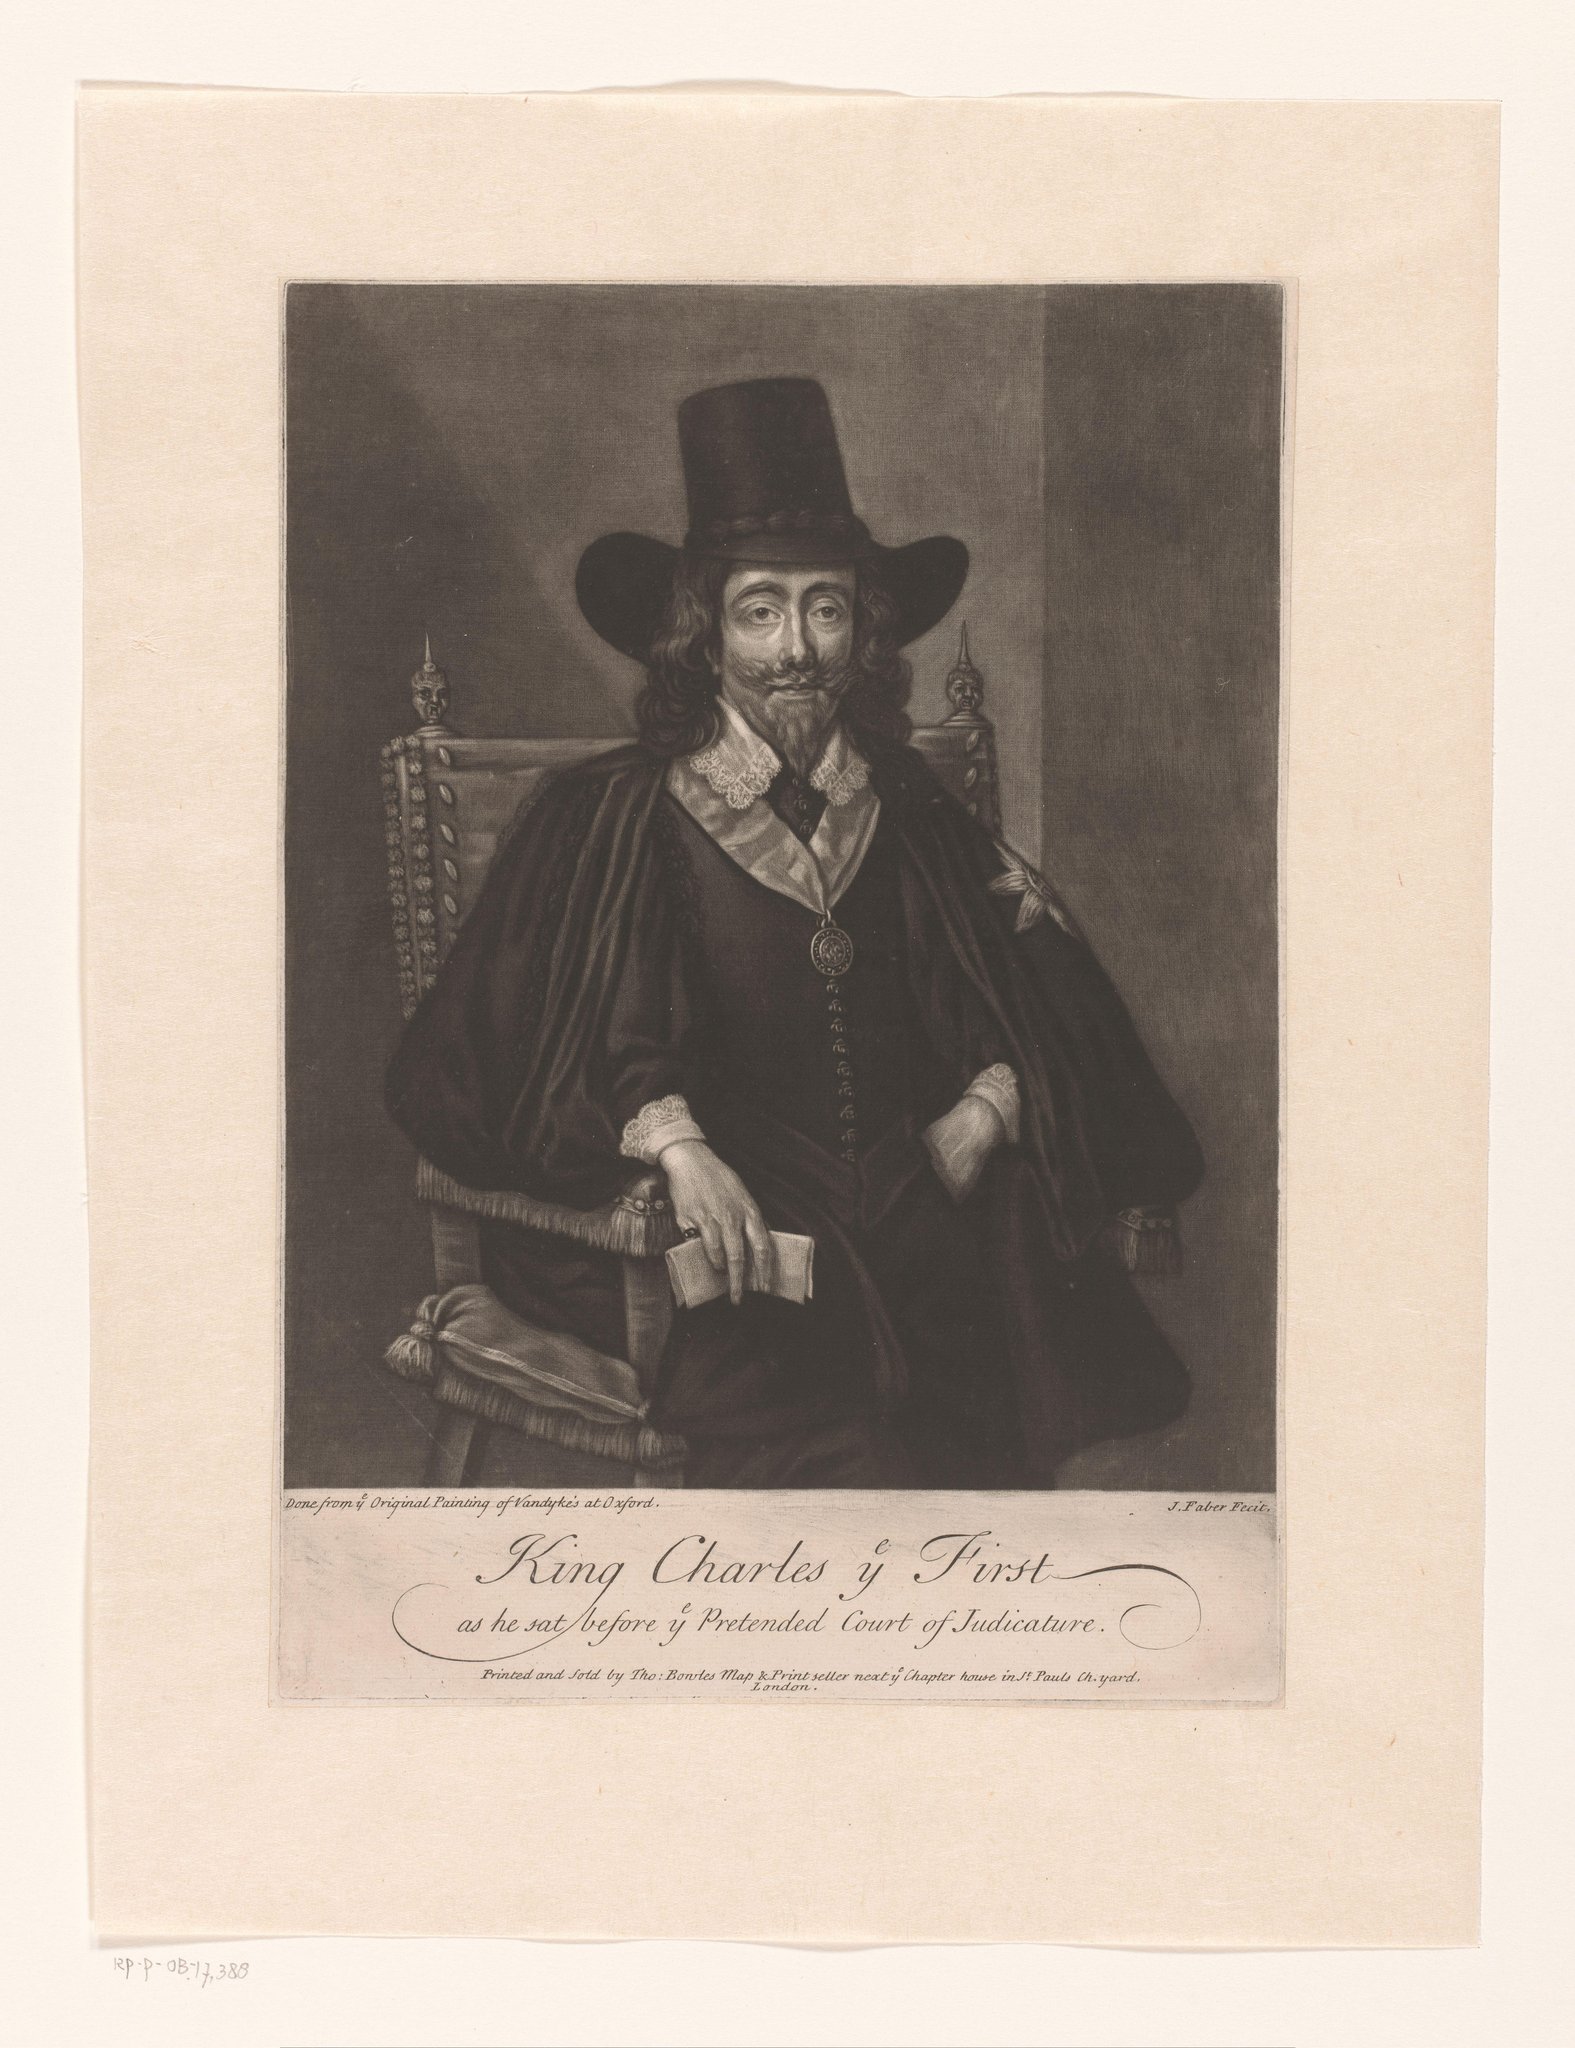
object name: print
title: Portret van Karel I, koning van Engeland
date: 1715-1766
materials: paper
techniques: mezzotint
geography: london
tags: london, karel i (koning van engeland), historical persons, knighthood order (garter)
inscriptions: collector's mark: Lugt 240